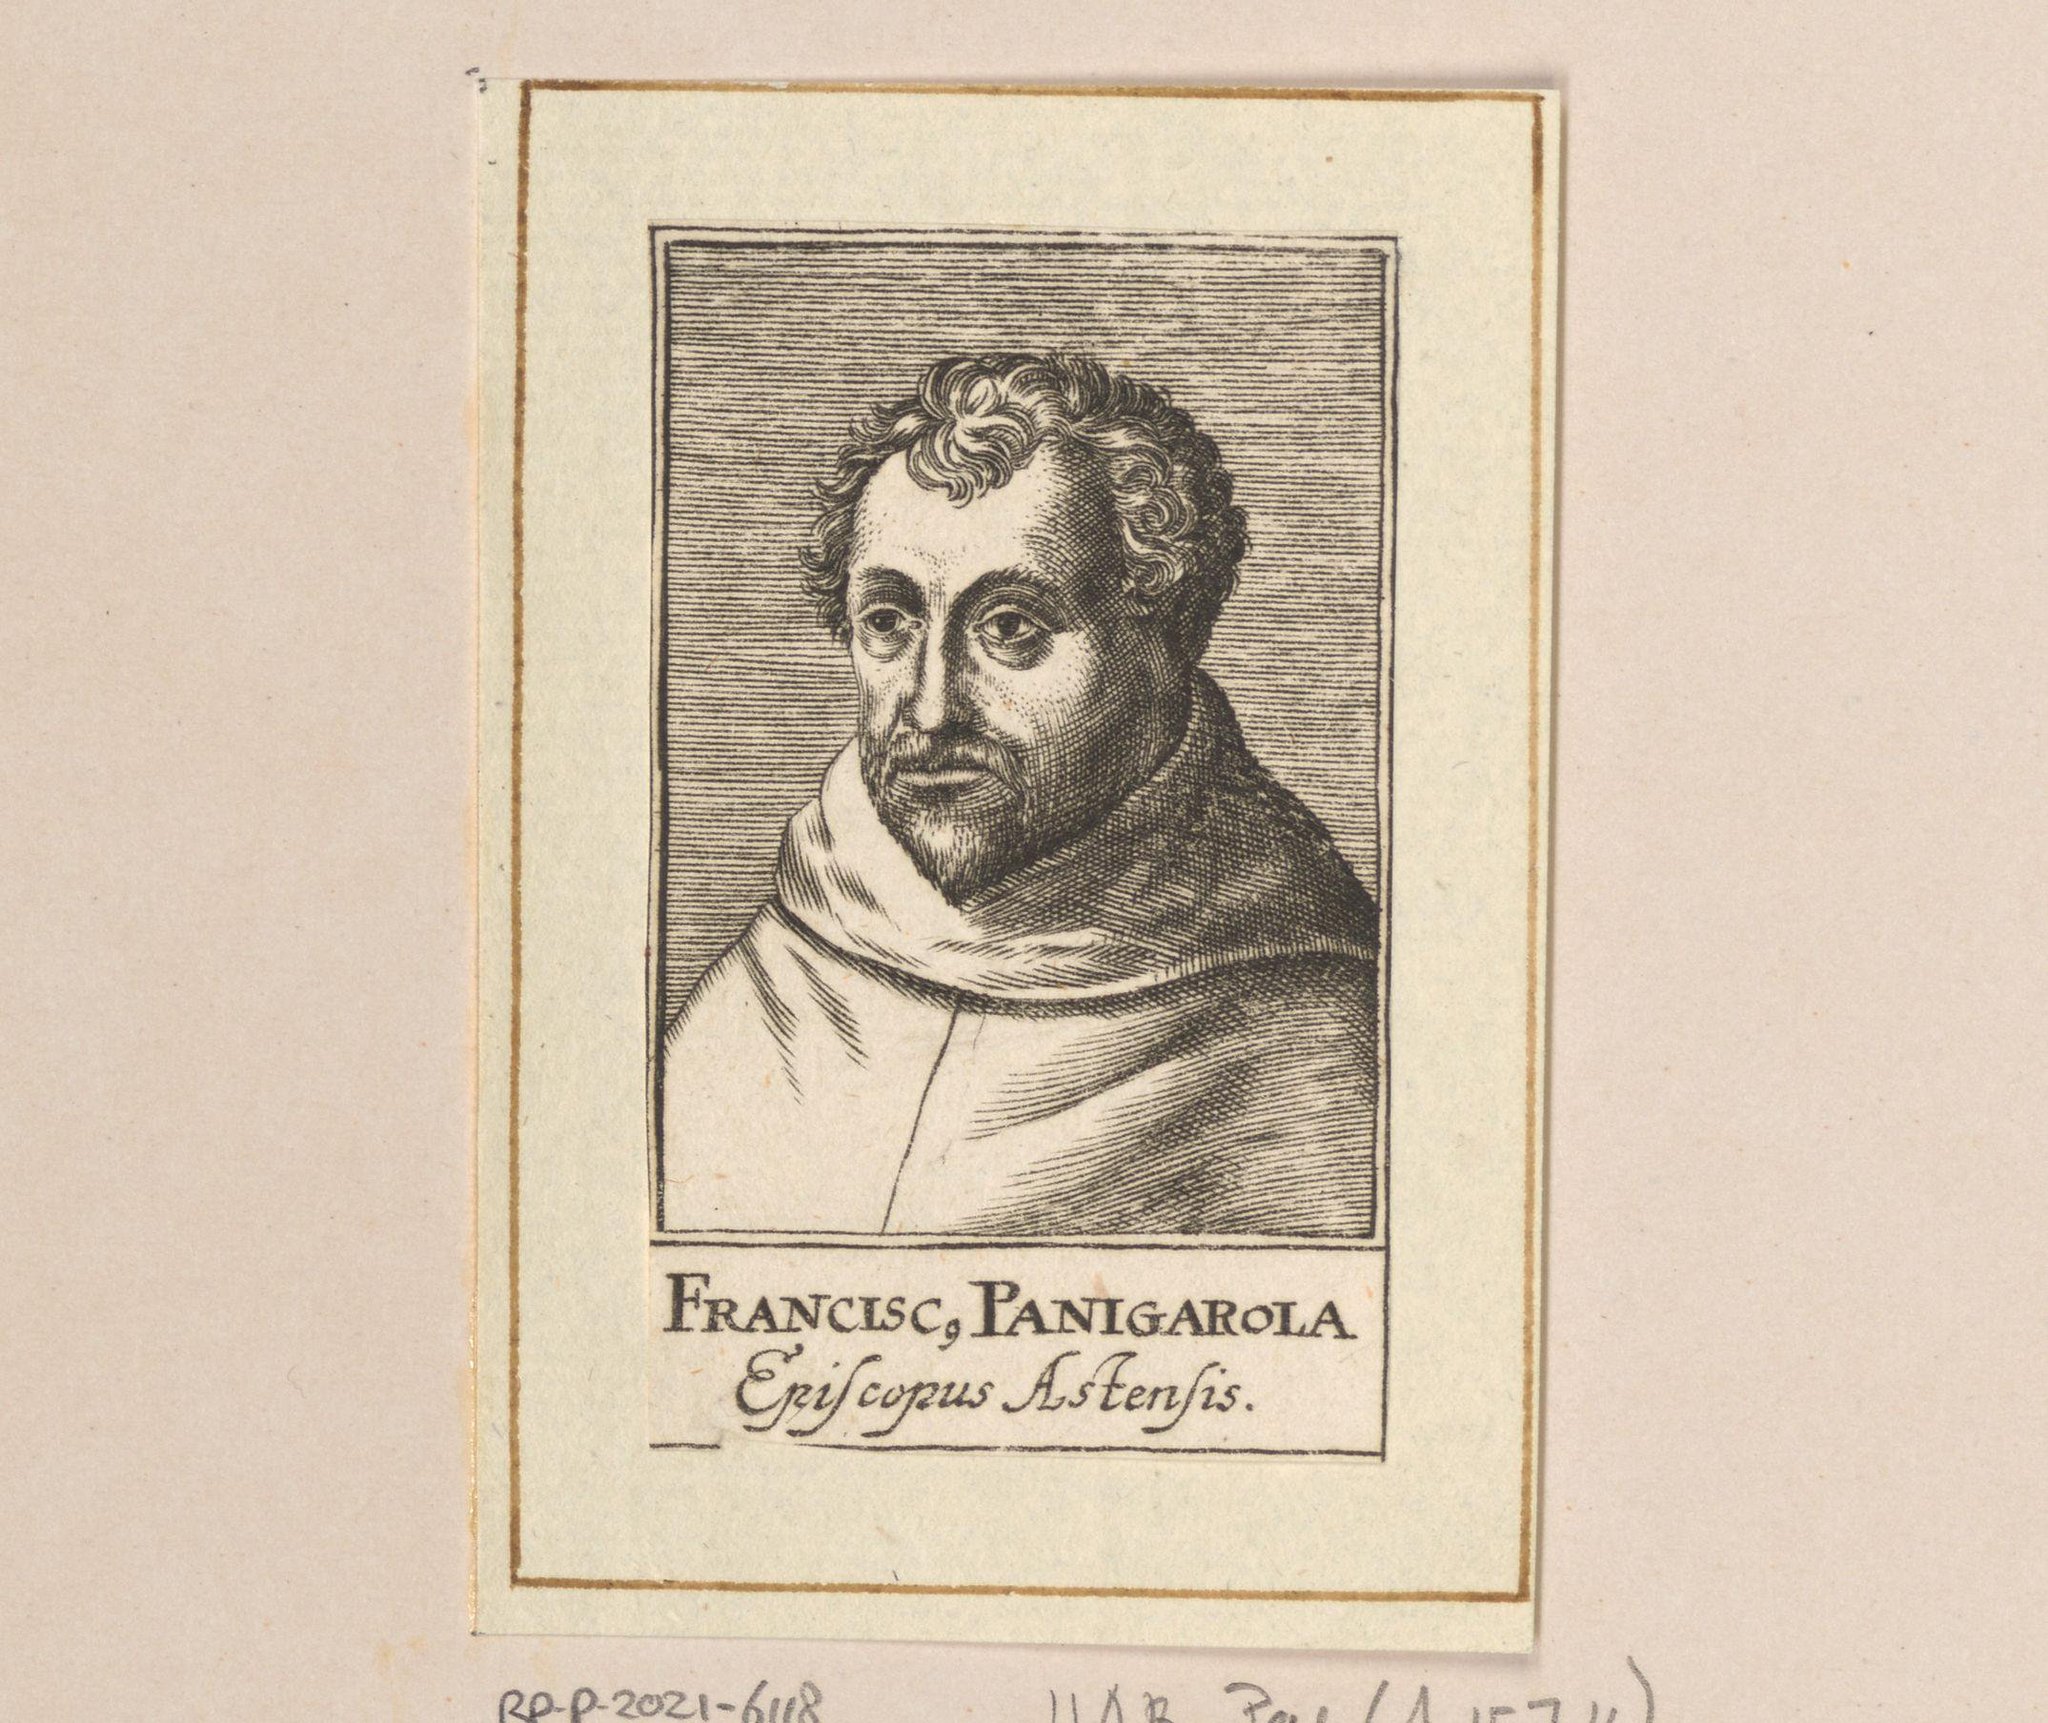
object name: print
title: Portret van Francesco Panigarola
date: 1688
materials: paper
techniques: engraving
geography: nuremberg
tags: adult man, historical persons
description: Prent uit: Freher, Paul. Theatrum virorum eruditione clarorum. Neurenberg: Johann Hoffmann, 1688.